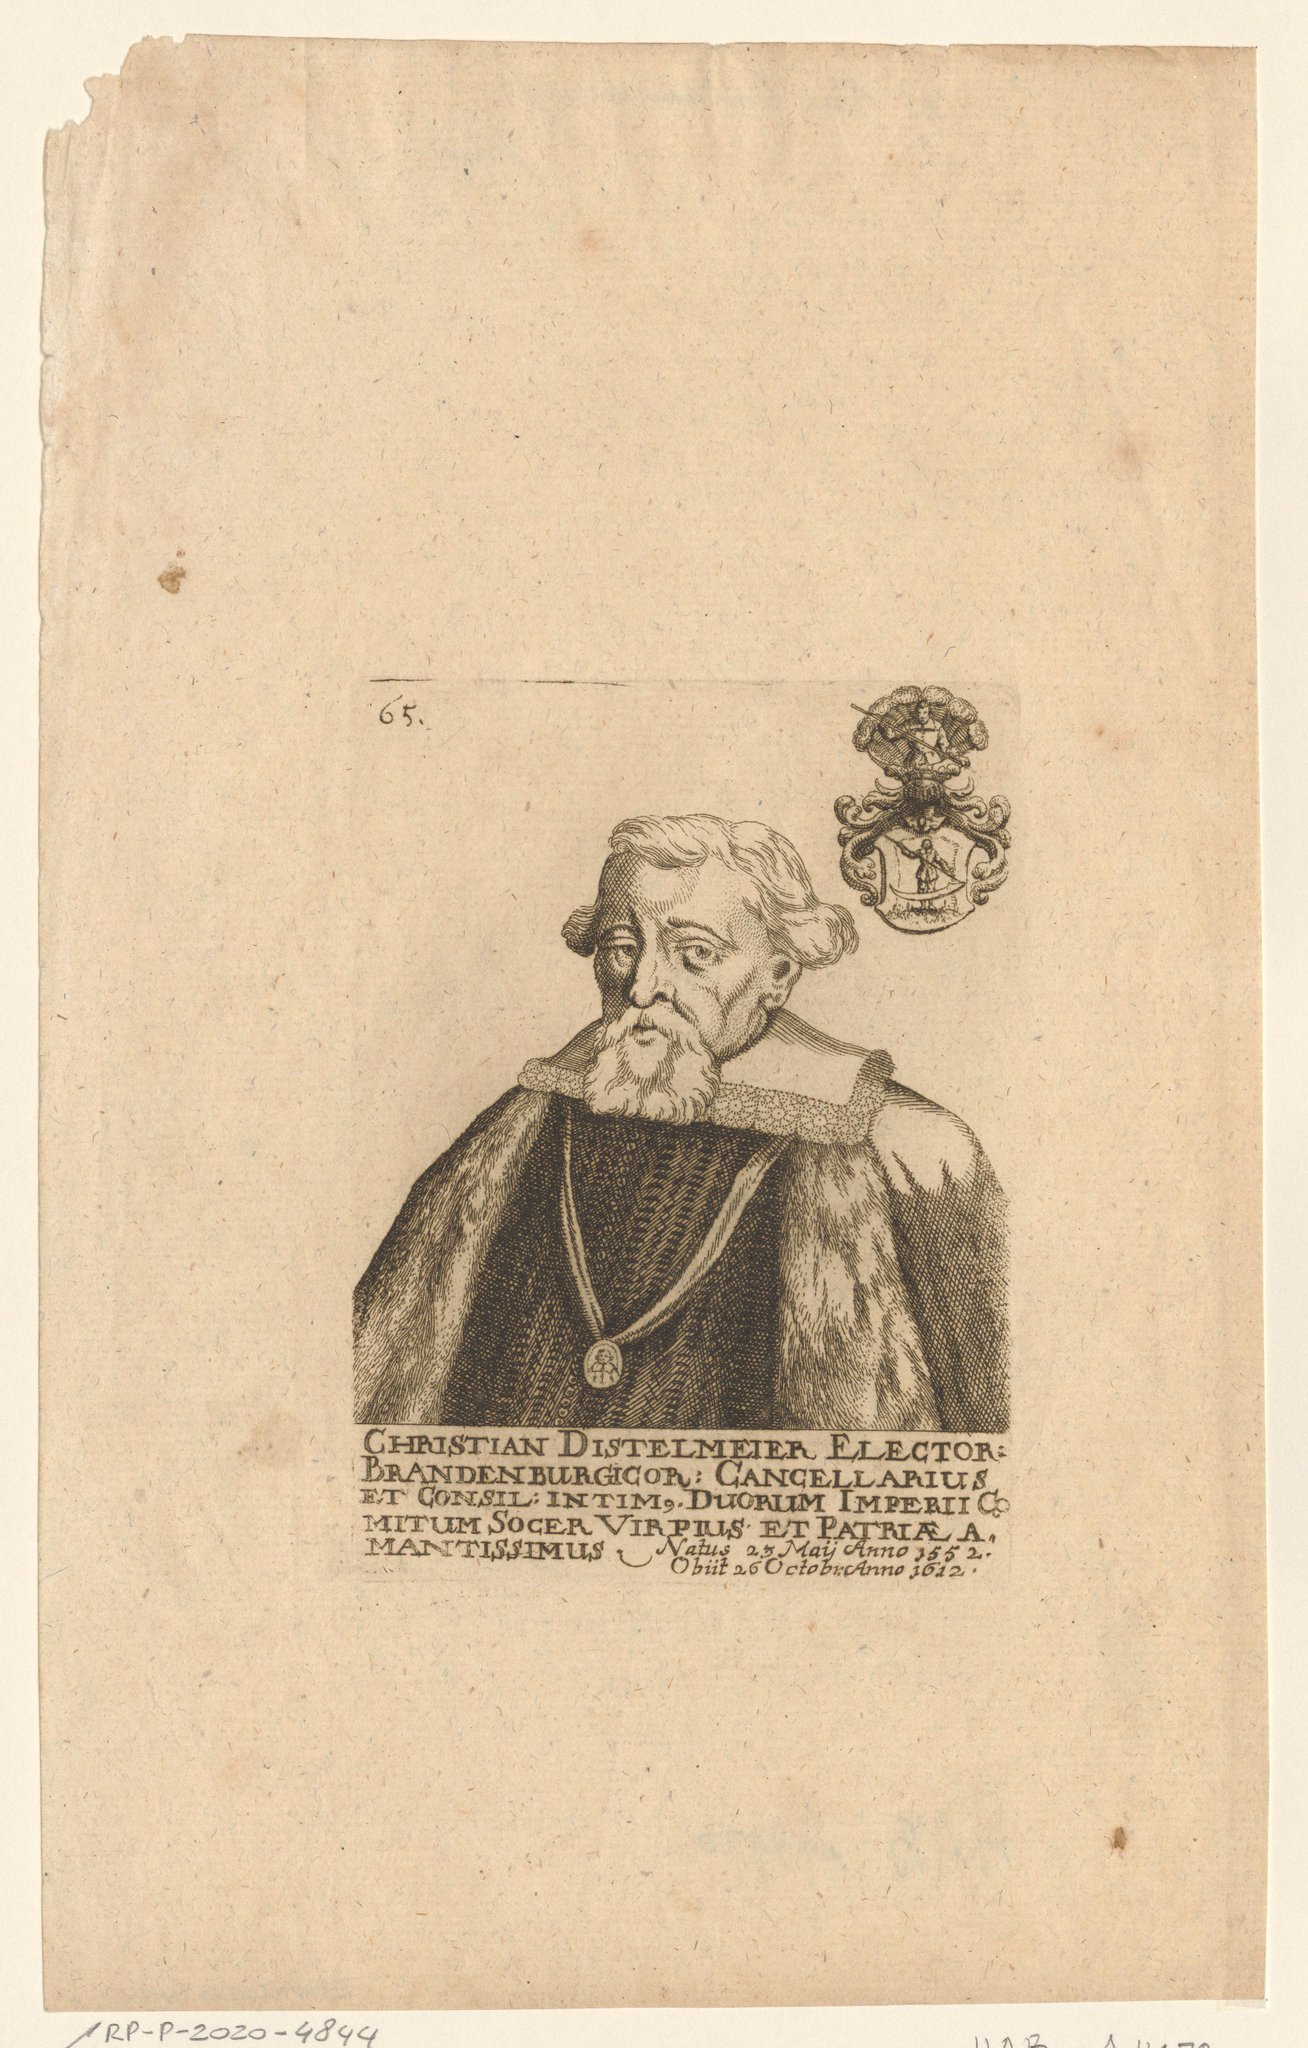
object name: print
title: Portret van Christian Distelmeyer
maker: Anonymous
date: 1671-1751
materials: paper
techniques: engraving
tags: historical persons, law and jurisprudence, armorial bearing, heraldry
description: De prent is uitgegeven als onderdeel van een serie. Later is de prent ook als boekillustratie gebruikt in: Küster, Georg Gottfried. Martin Friedrich Seidels Bilder-Sammlung in welcher hundert, gröstentheils in der Mark Brandenburg (…). Berlijn: Buchladen bey der Real-Schule, 1751. Het is onduidelijk tot welke uitgave de huidige prent behoort.